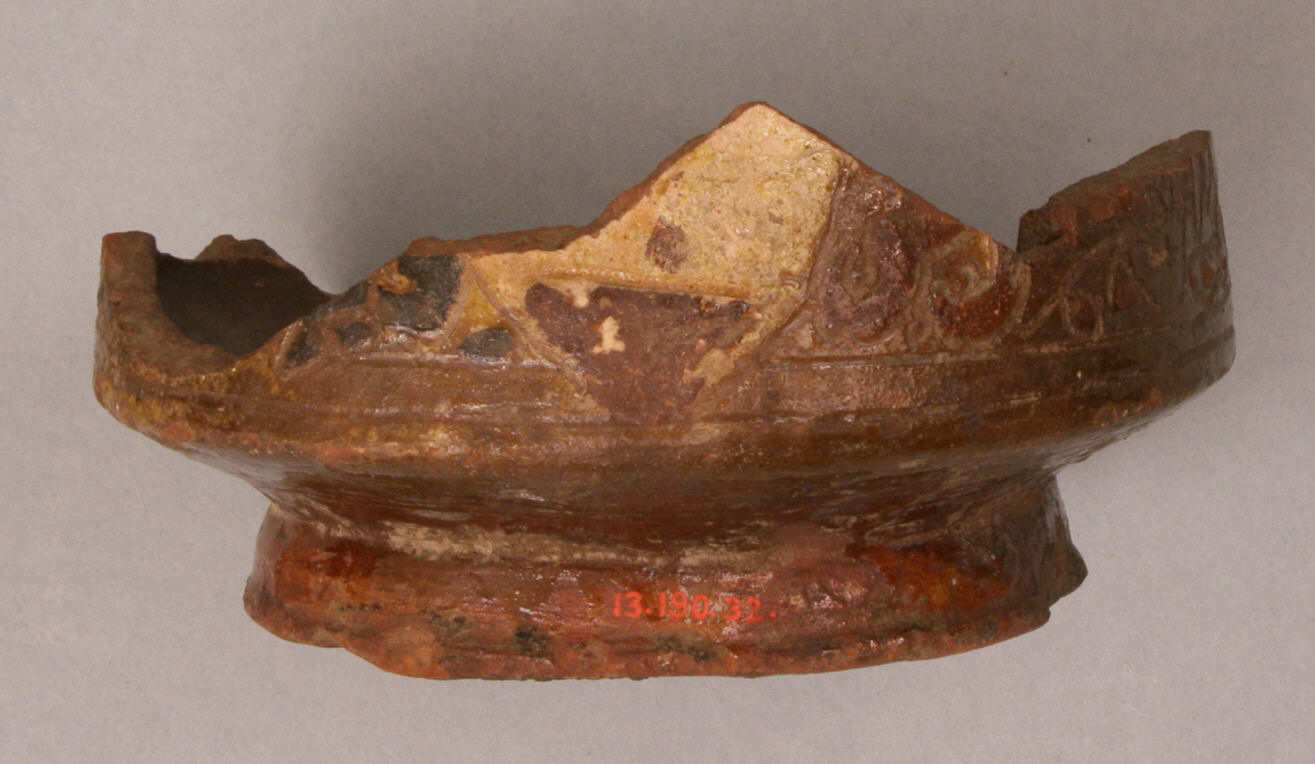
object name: ceramic fragment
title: Fragment of a Bowl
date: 1301-1500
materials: earthenware, glaze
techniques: coloring, incising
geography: egypt